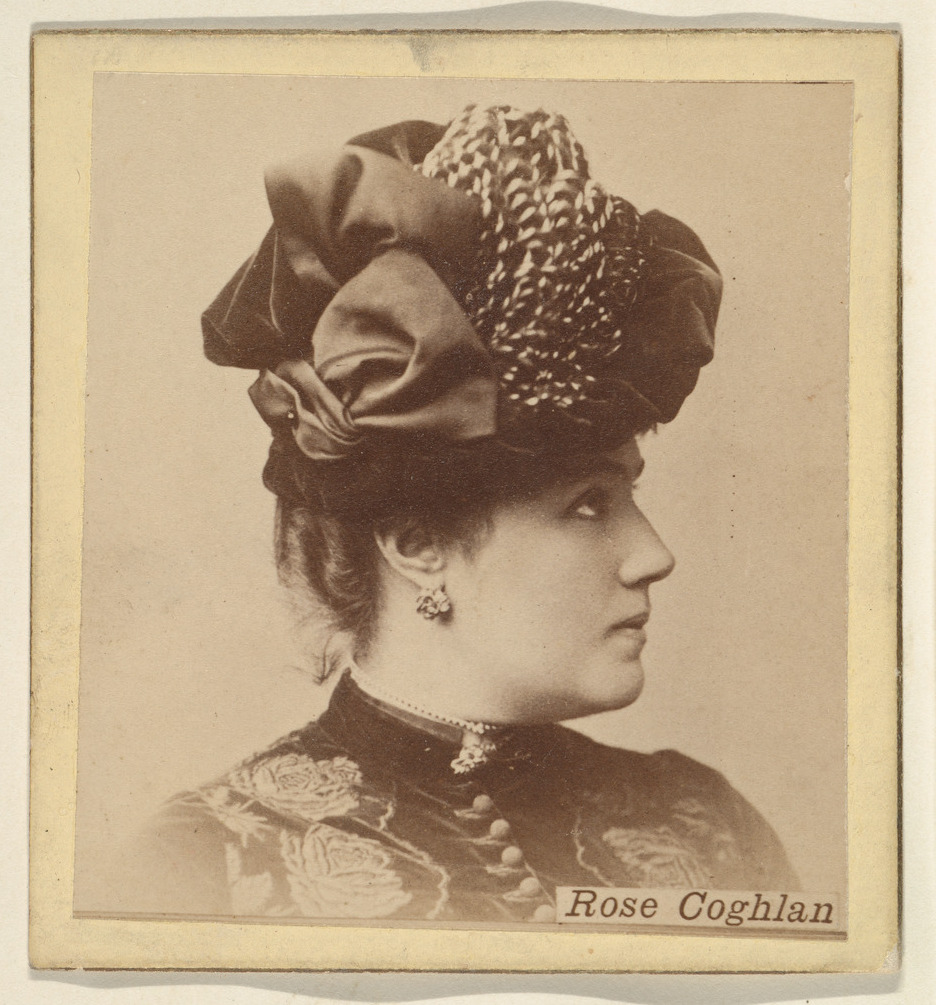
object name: photograph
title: Rose Coghlan, from the Actresses series (N246), Type 2, issued by Kinney Brothers to promote Sporting Extra Cigarettes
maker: kinney brothers tobacco company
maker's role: publisher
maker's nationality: american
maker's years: 1869-2011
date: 1890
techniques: albumen silver print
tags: women,actresses